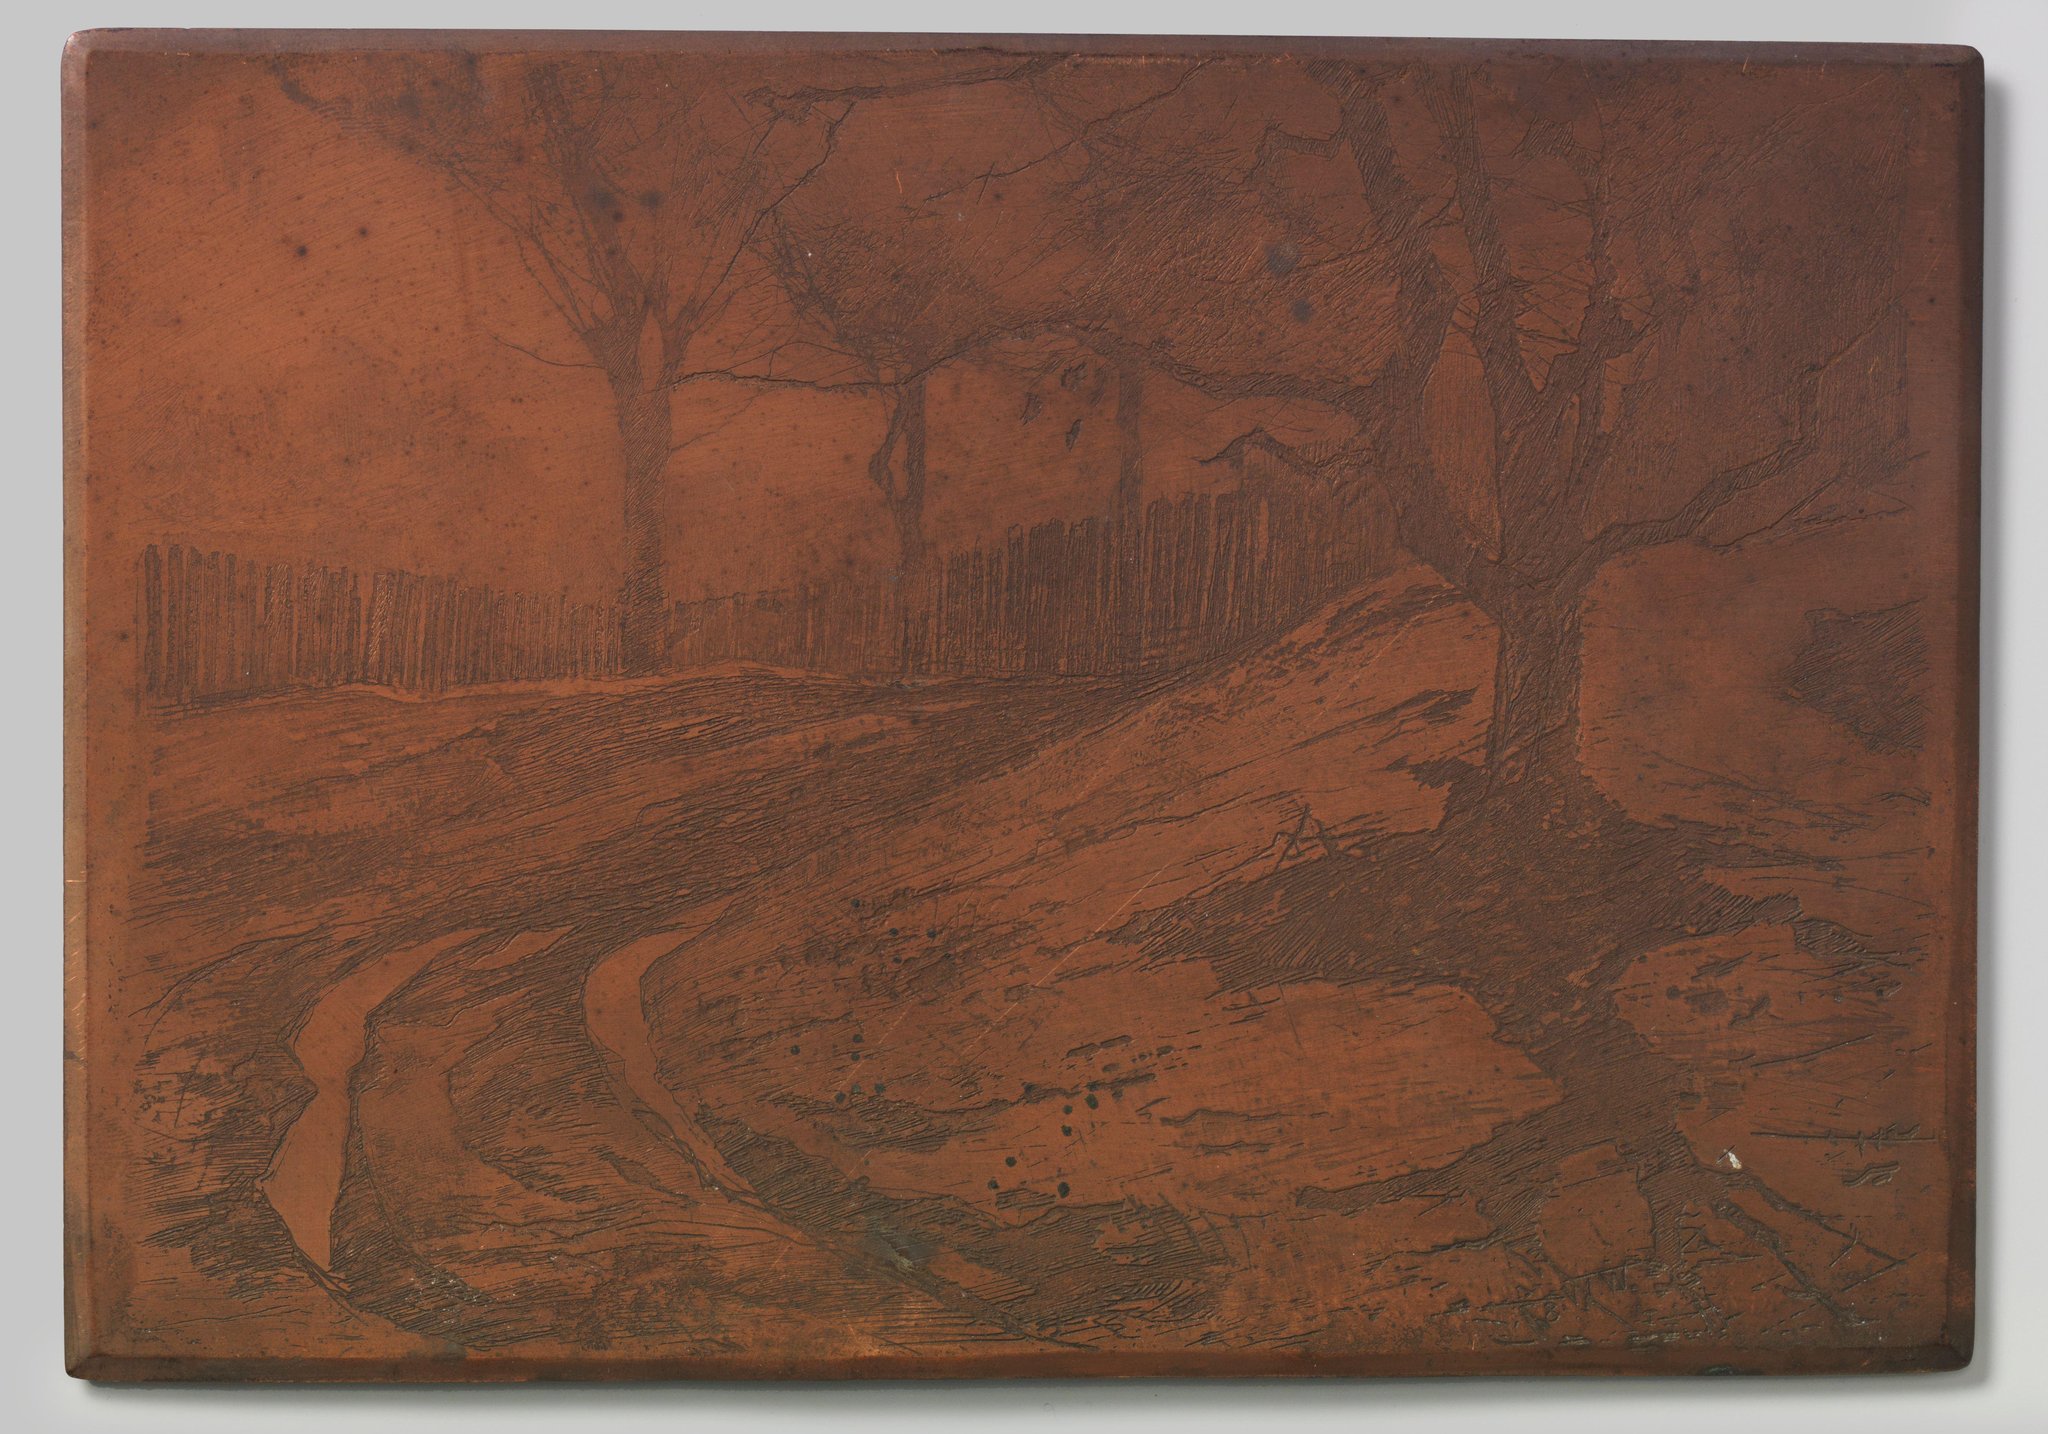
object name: copper plate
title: Duinwegje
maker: willem witsen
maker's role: draughtsman, painter, print maker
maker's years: 1860-1923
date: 1887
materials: copper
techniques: etching